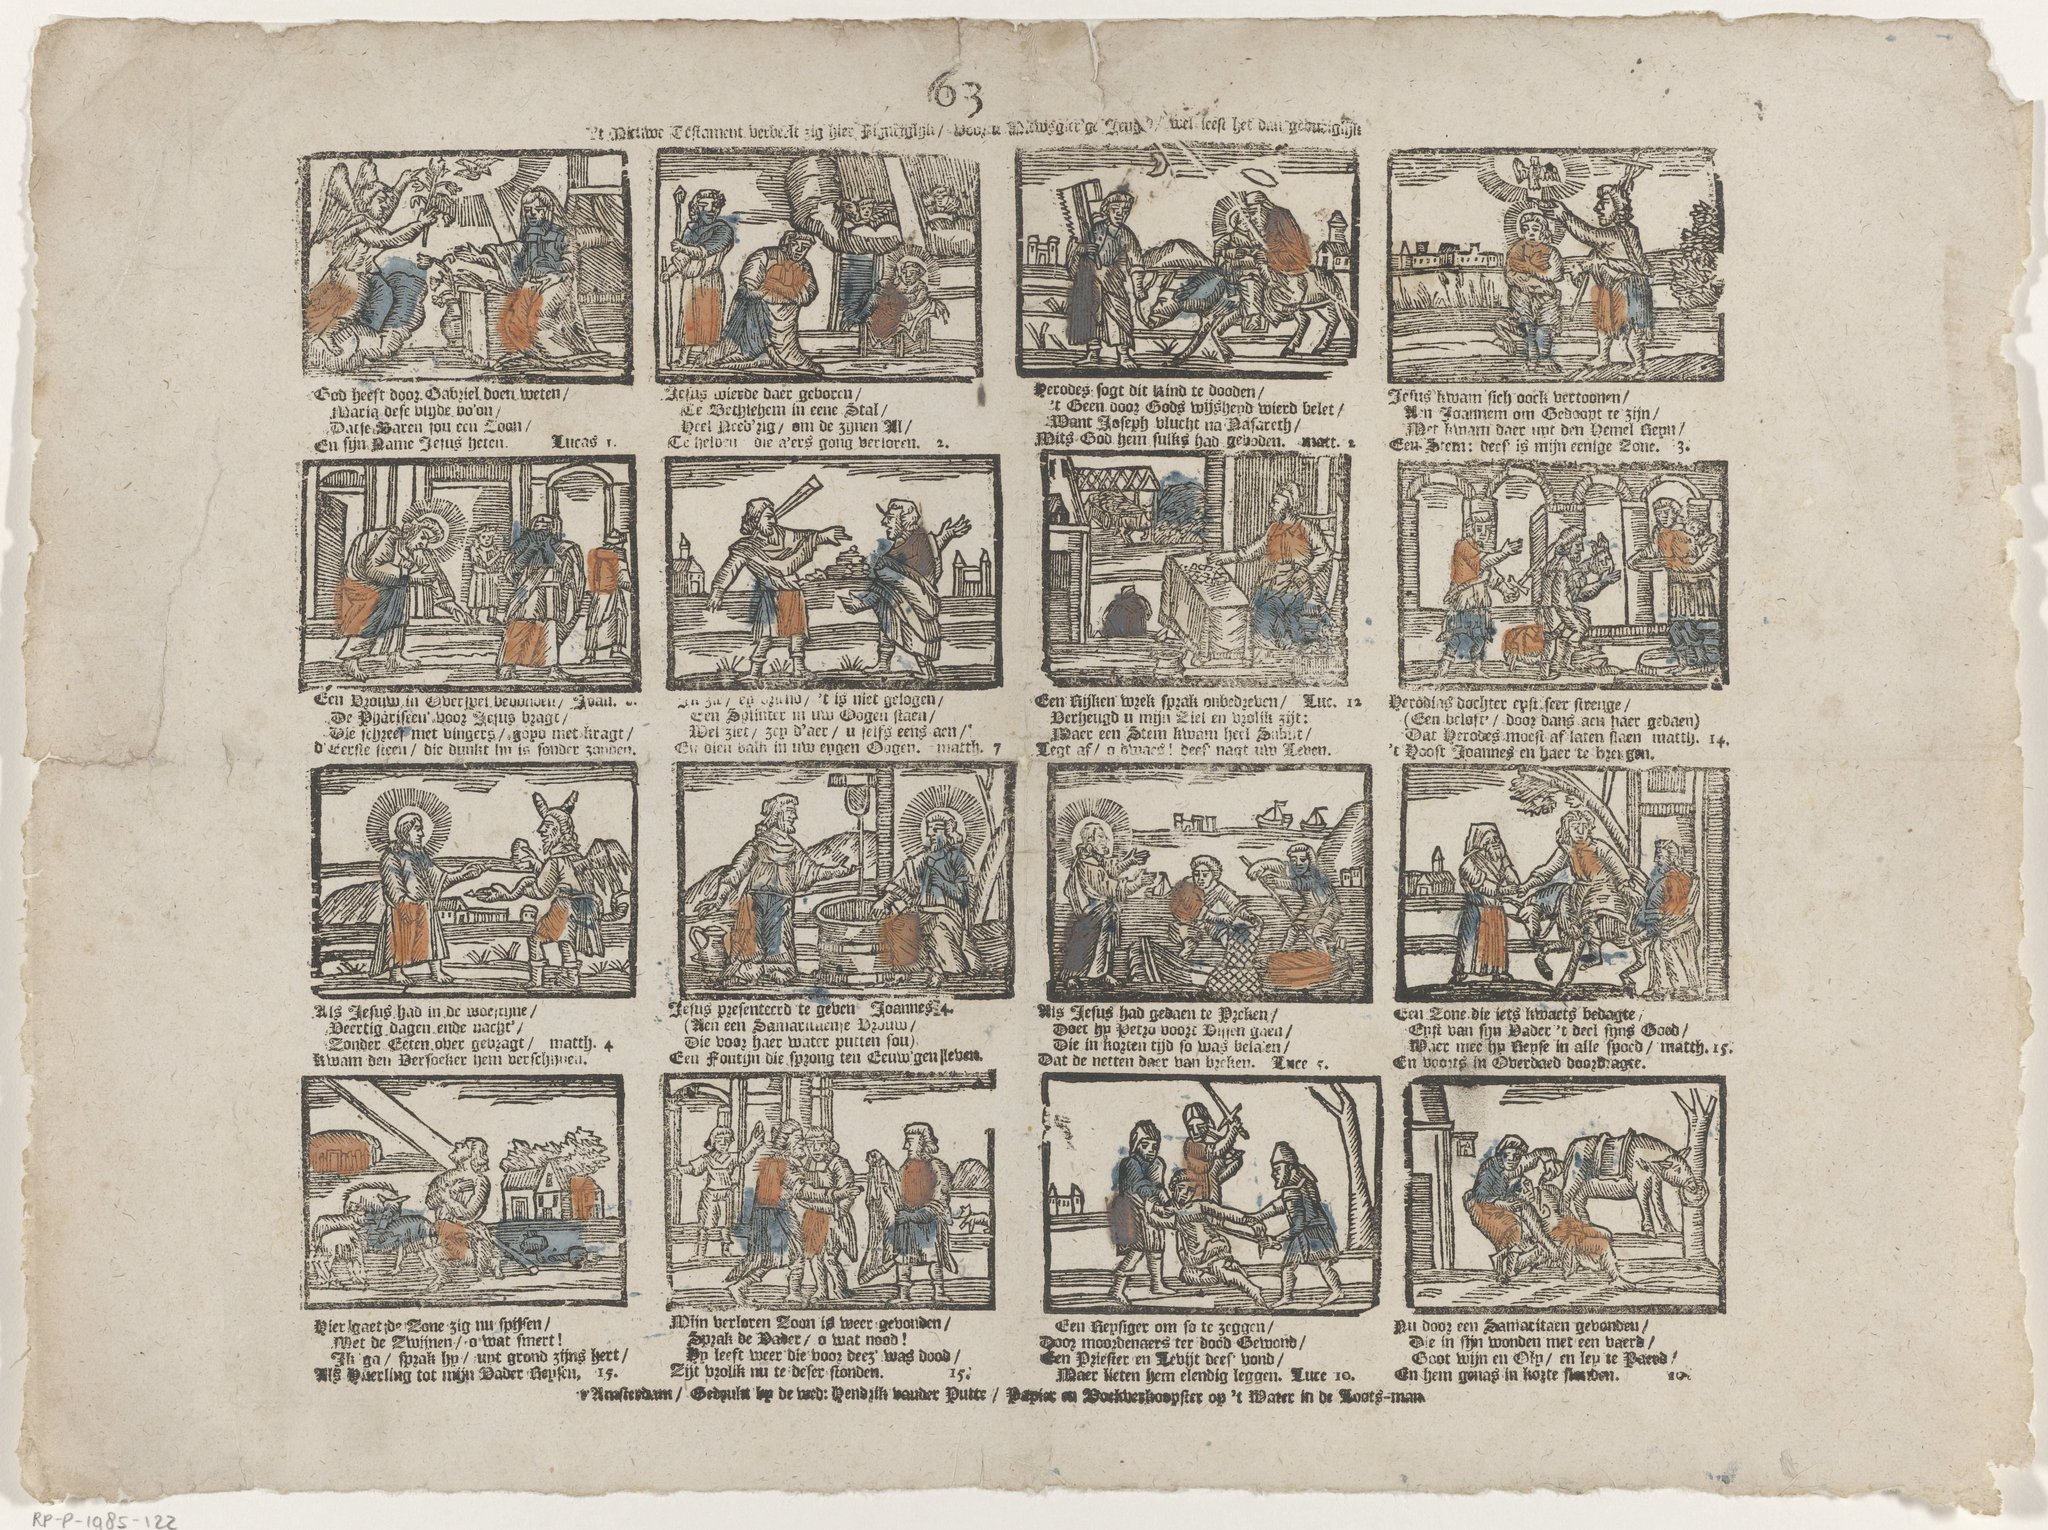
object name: popular print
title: 't Nieuwe Testament verbeelt zig hier figuriglijk / Voor u niewgier'ge jeugd / wel leest het dan geduriglijk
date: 1765-1767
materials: paper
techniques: colour, letterpress printing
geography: netherlands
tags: new testament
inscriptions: collector's mark: Lugt 2228, collector's mark: Lugt 2760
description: Blad met 16 voorstellingen van verhalen uit het Nieuwe Testament, zoals de Anunciatie en de verzoeking van Christus in de woestijn. Onder elke afbeelding een vierregelig vers en een verwijzing naar de bijbehorende Bijbeltekst. Genummerd midden boven: 63.